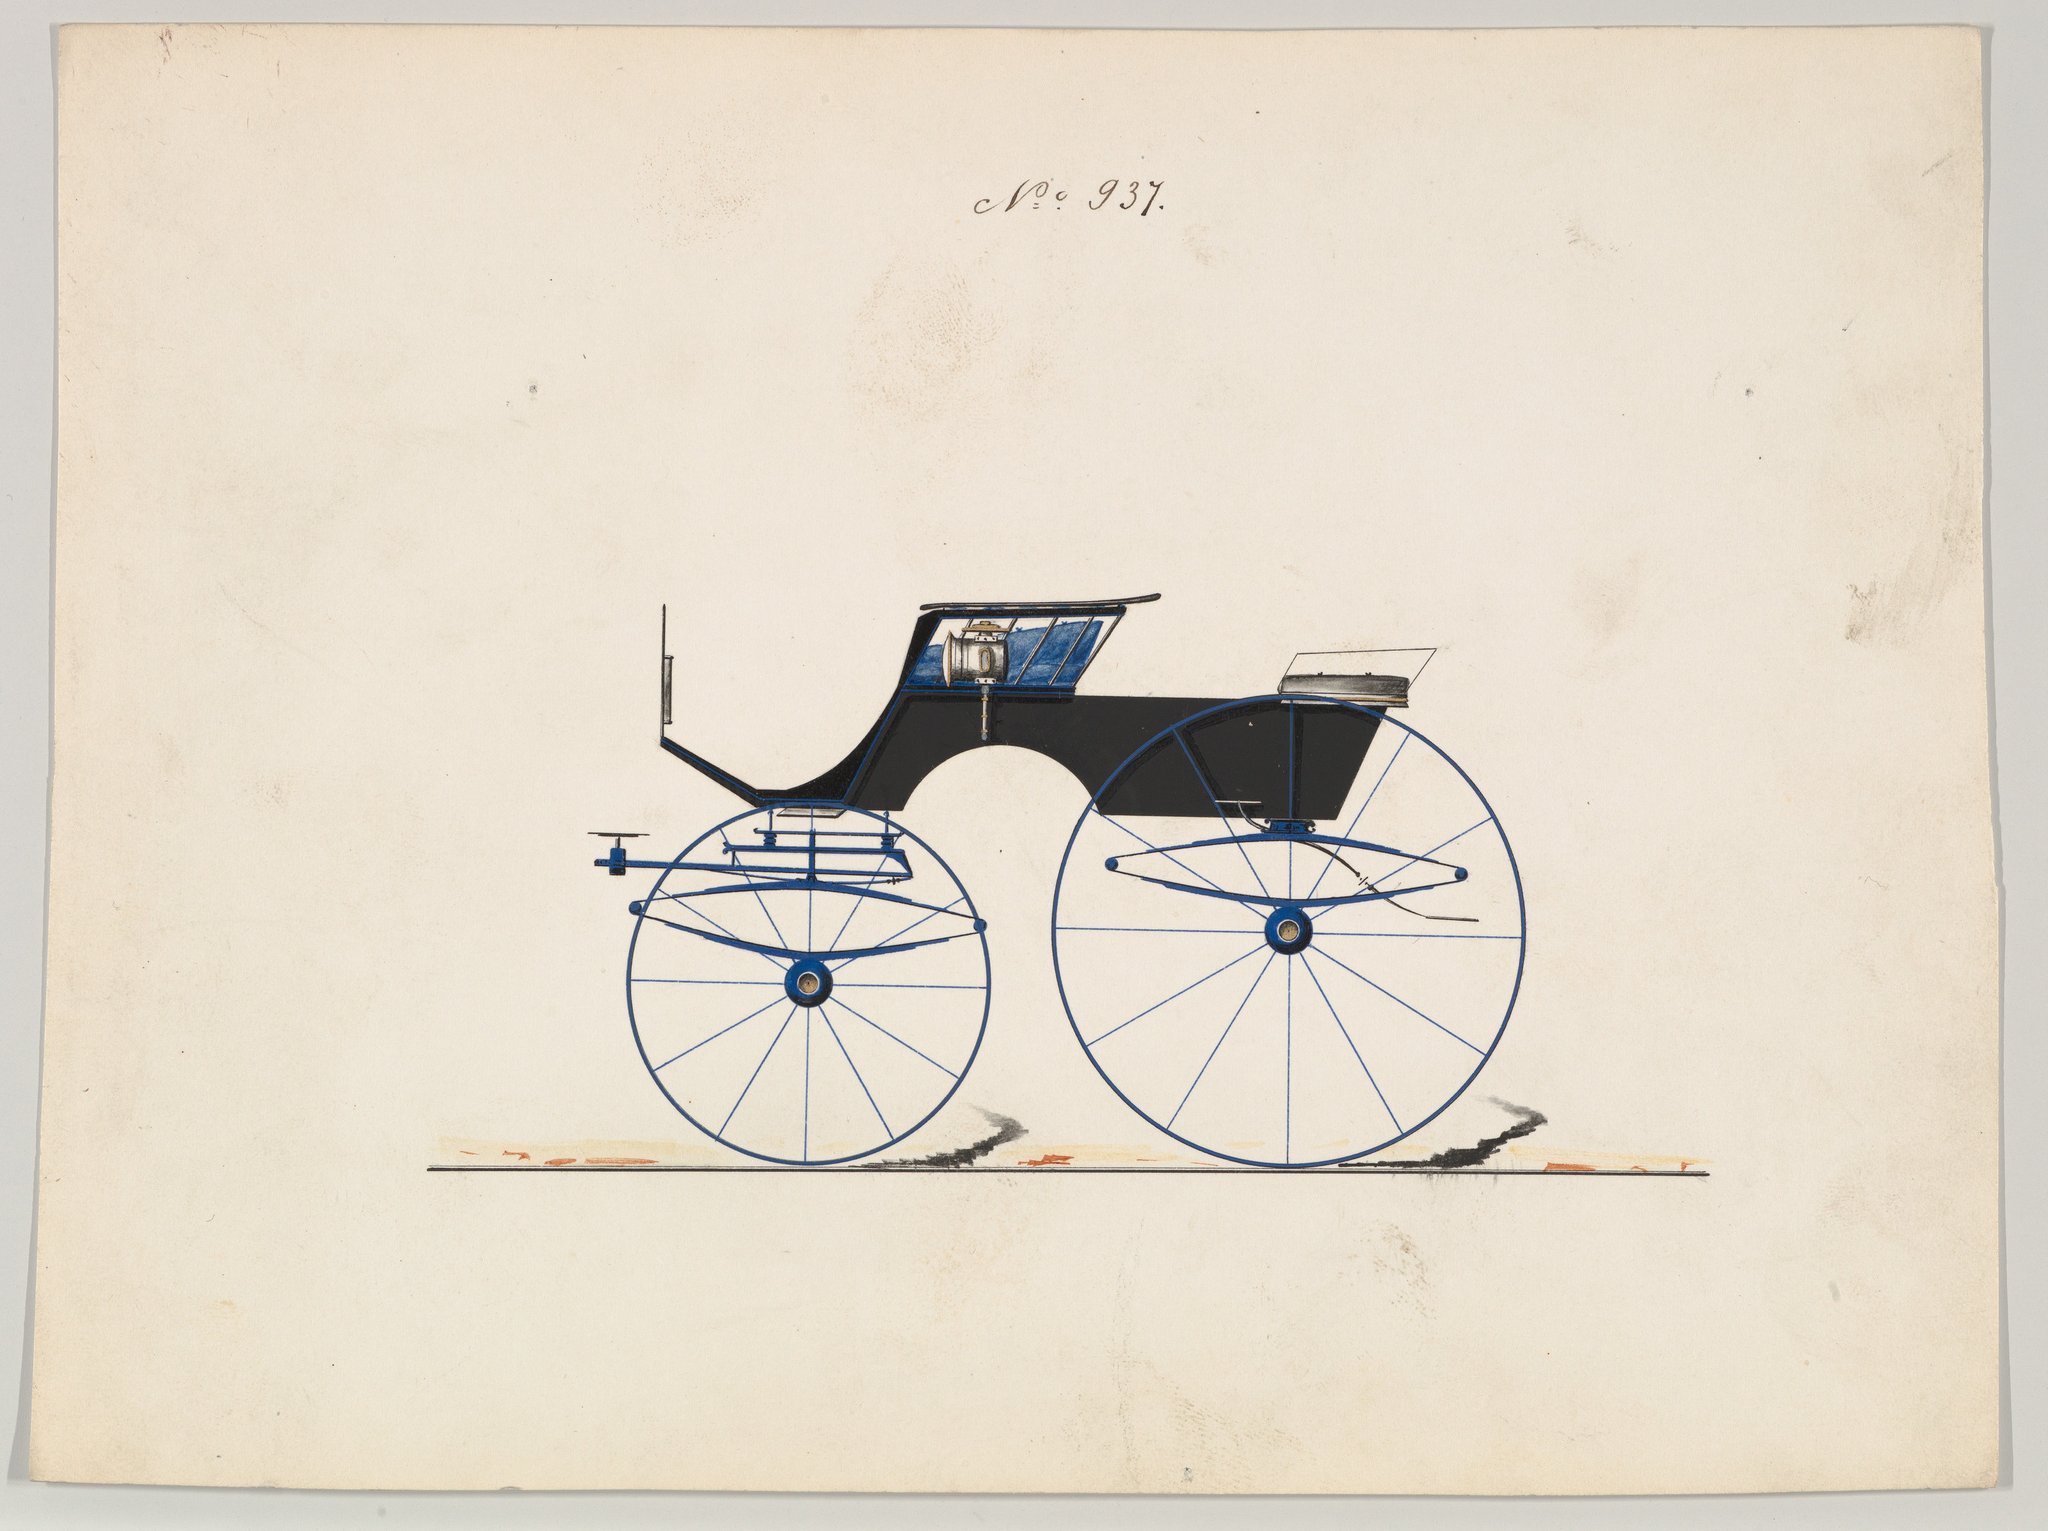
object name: drawing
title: T-Cart Phaeton #937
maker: brewster & co.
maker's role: manufacturer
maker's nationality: american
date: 1850-1870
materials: gouache, gum arabic, ink, watercolor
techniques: pen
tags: carriages